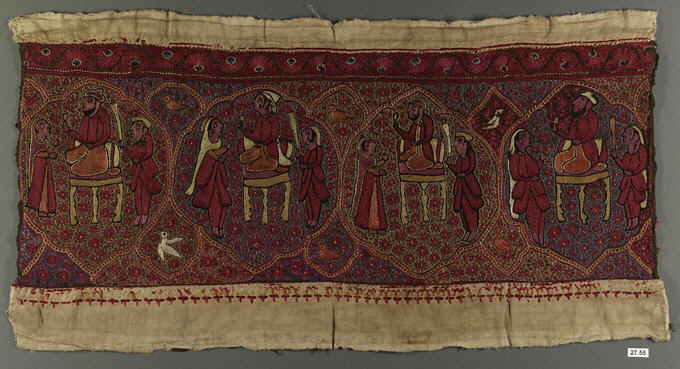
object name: band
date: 1801-1833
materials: linen, silk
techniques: embroidery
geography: india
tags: birds,men,women